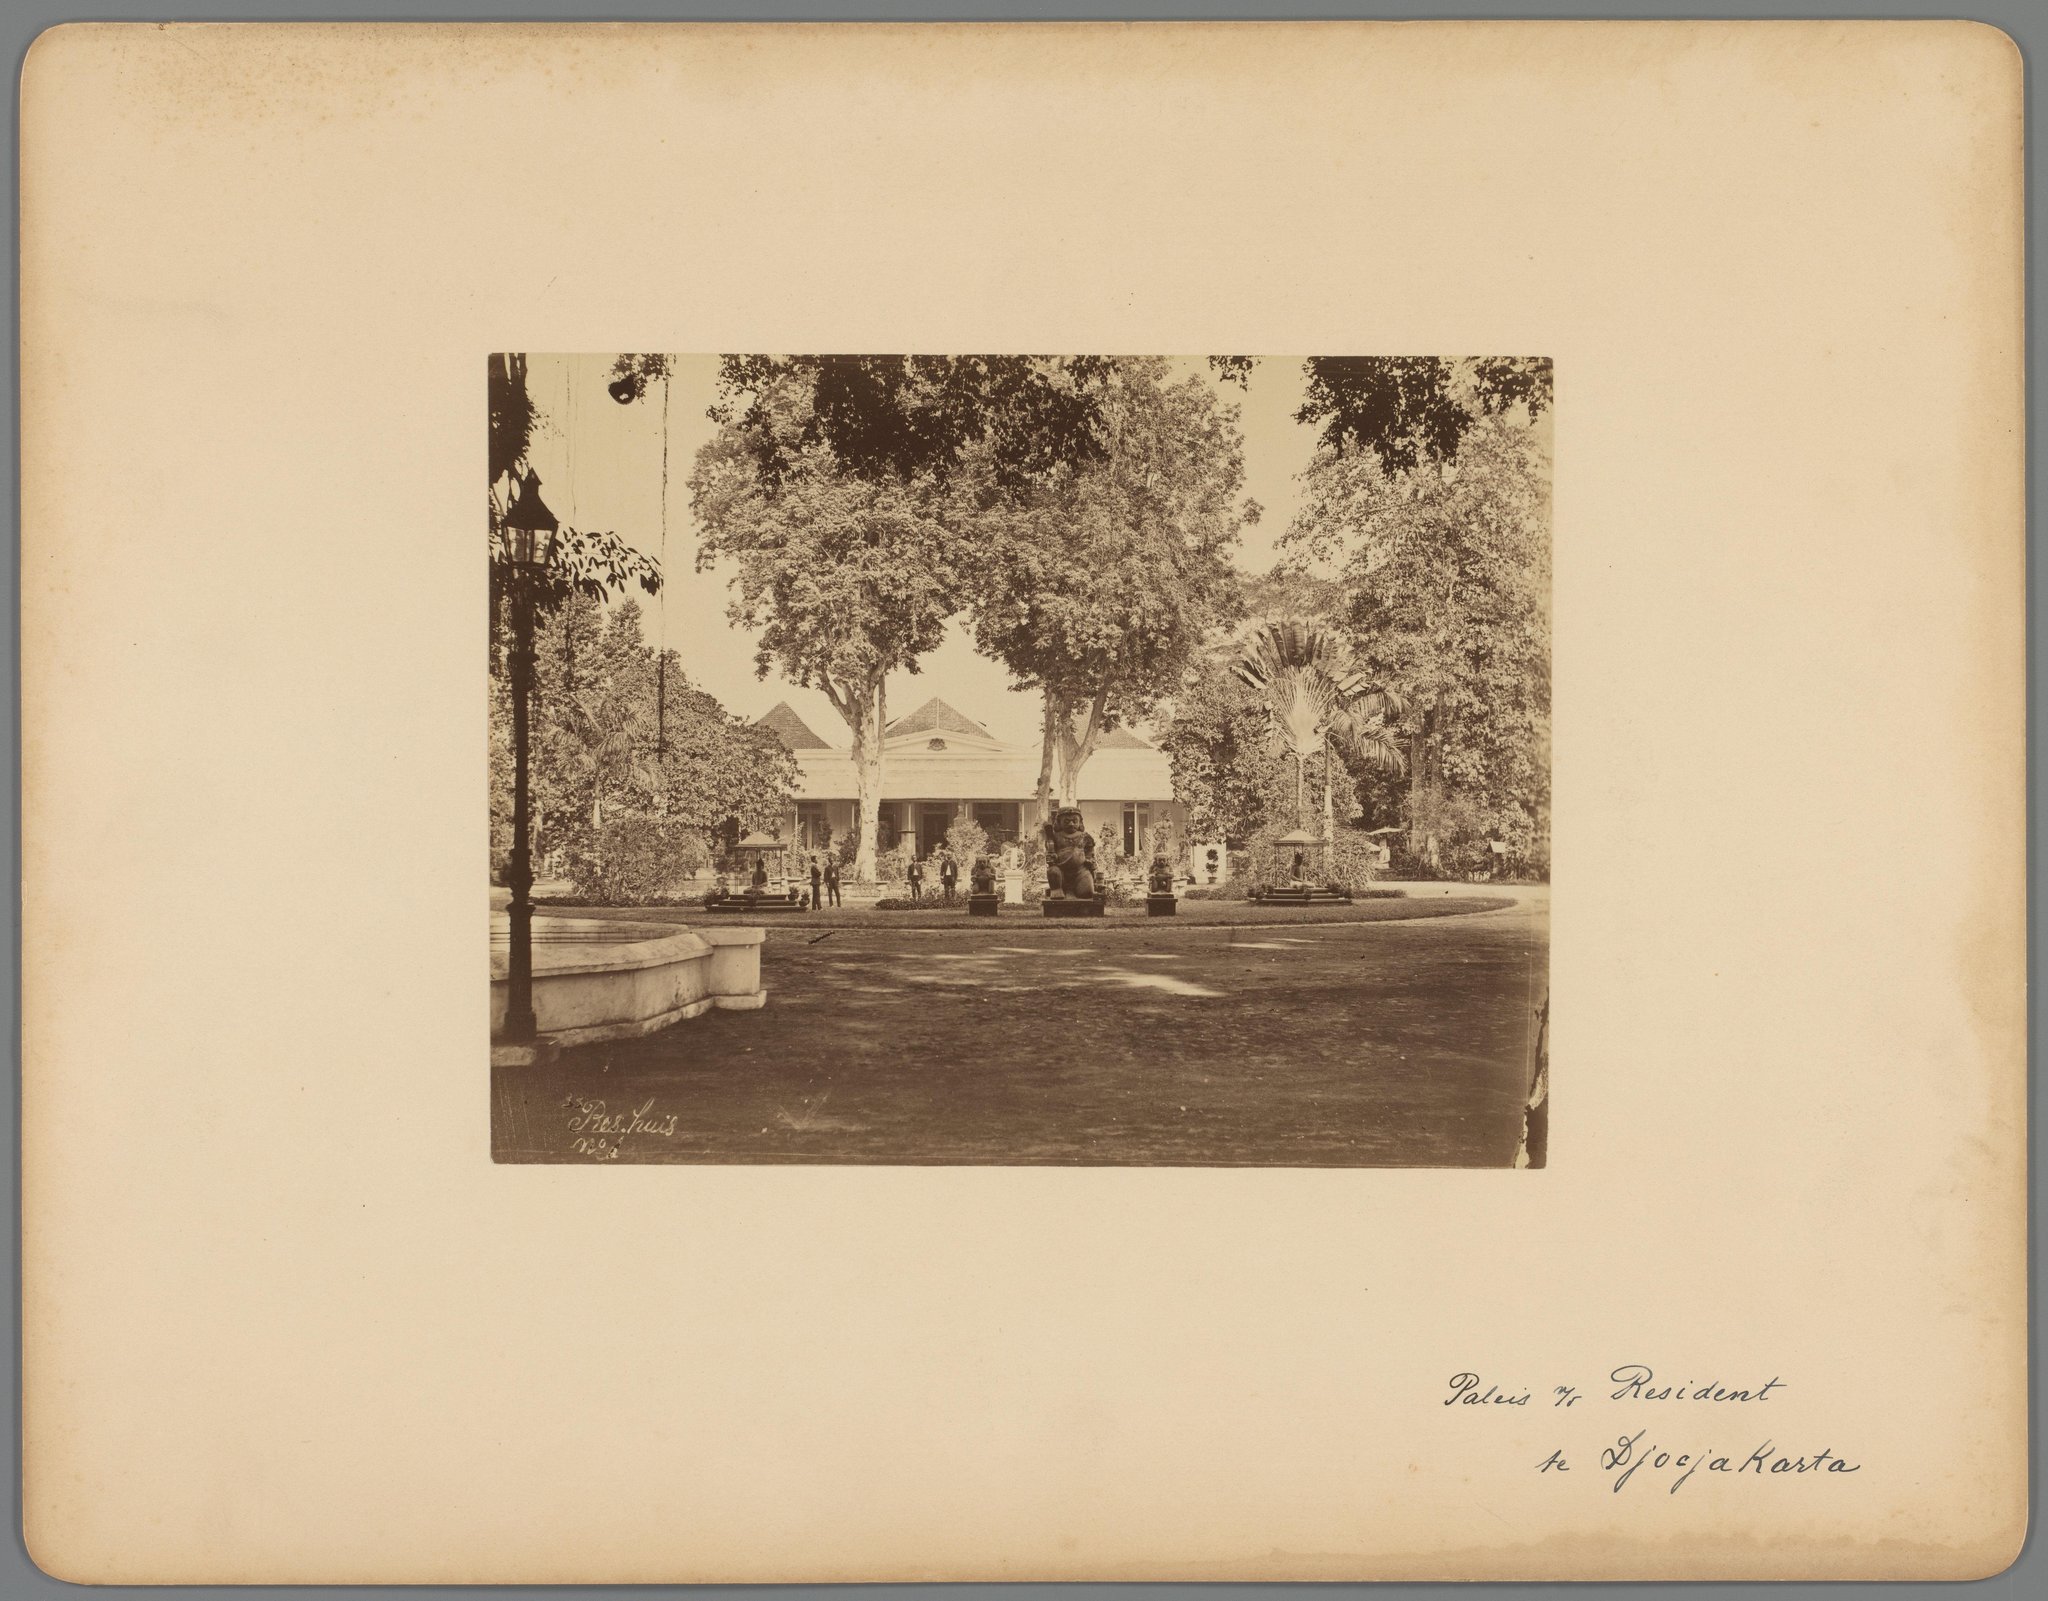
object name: photograph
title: Res. huis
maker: Anonymous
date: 1851-1900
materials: cardboard, paper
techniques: albumen print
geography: jogjakarta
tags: exterior ~ representation of a building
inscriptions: number: ‘No 1’, inscription: ‘FOTO’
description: Deze foto zat oorspronkelijk in prentenkabinet RP-F-AA3192.